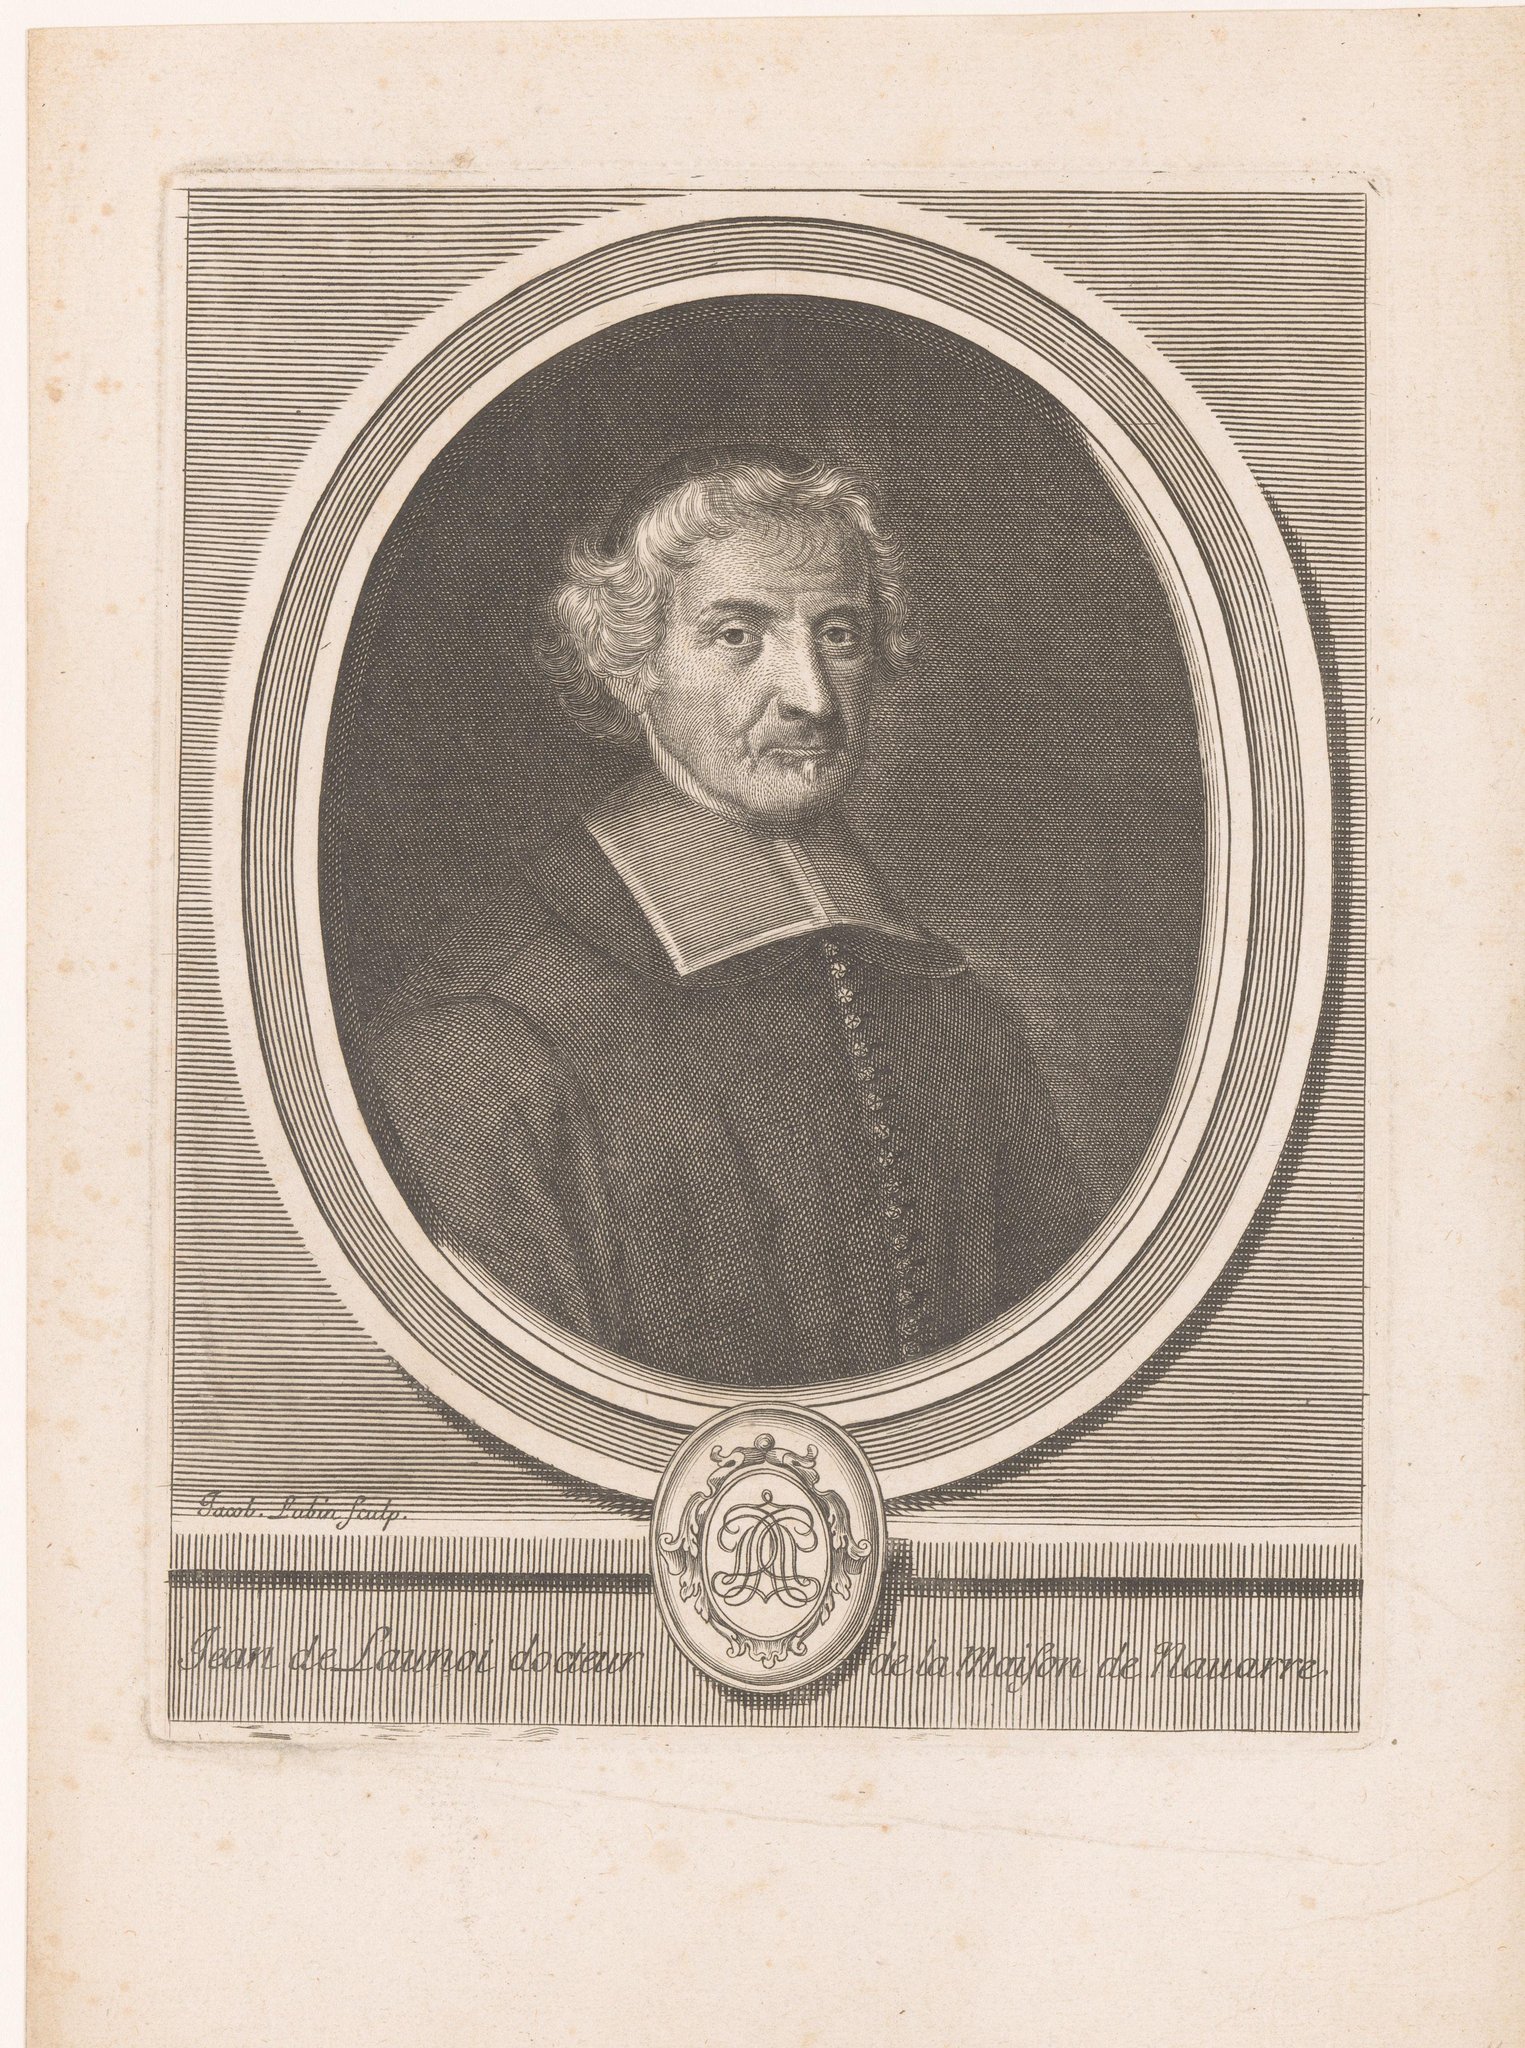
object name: book illustration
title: Portret van Jean de Launoy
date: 1696-1700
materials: paper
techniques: engraving, etching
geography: paris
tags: historical persons, historical disciplines; philology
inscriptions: collector's mark: Lugt 2228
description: Prent uit: Perrault, Charles. Les hommes illustres qui ont paru en France pendant ce siècle. Parijs: Antoine Dezallier, 1696-1700.